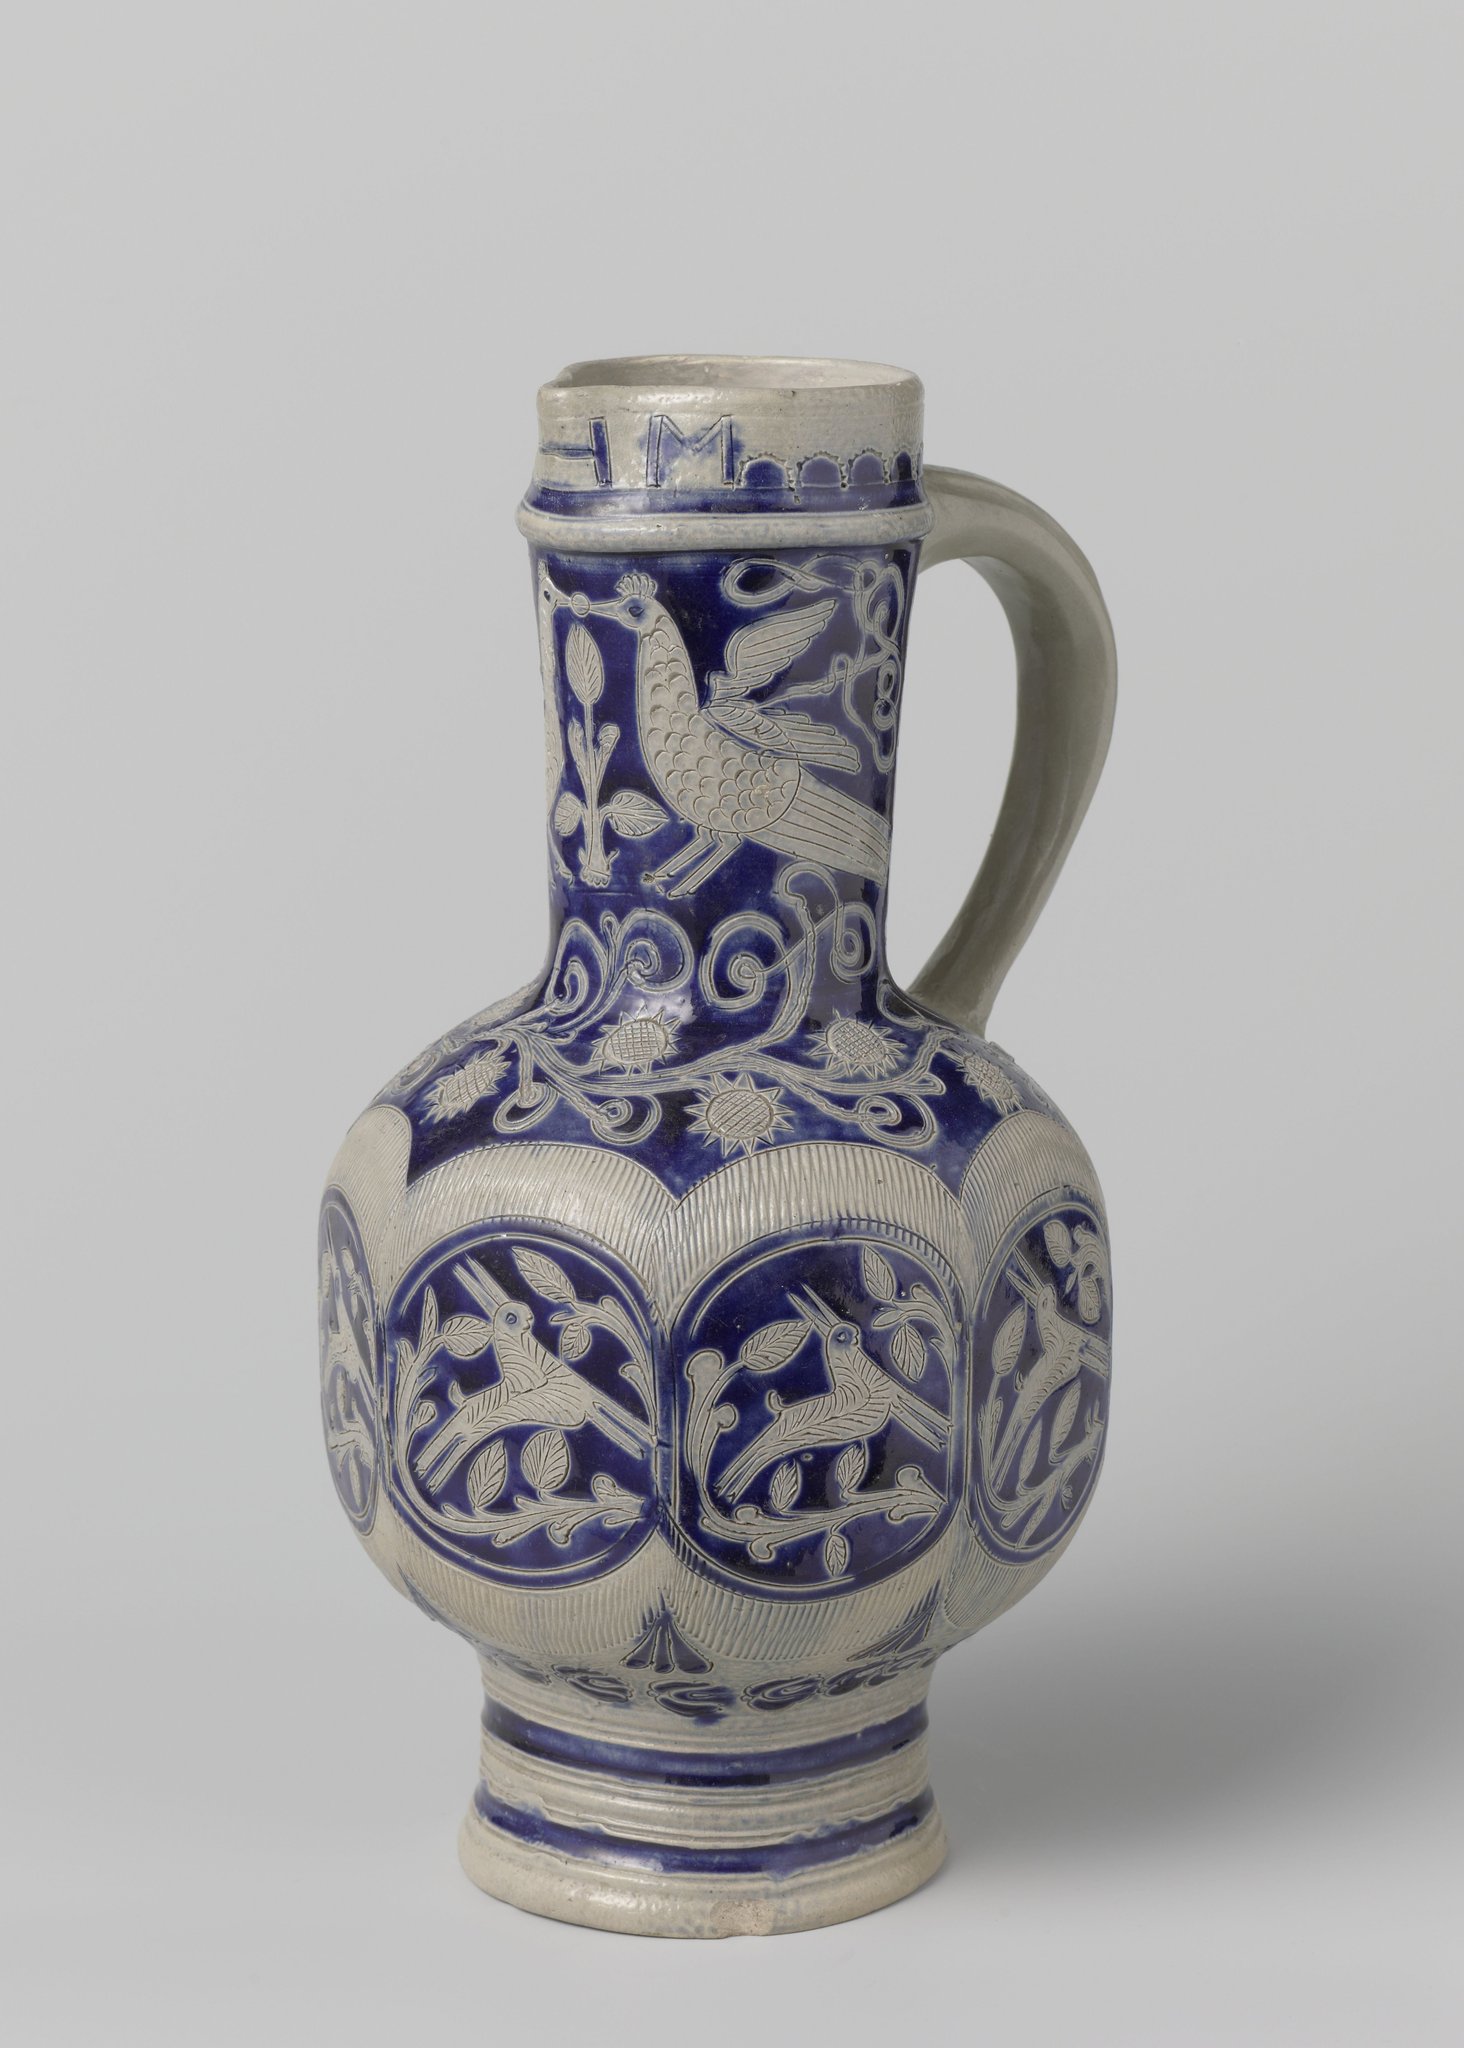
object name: ewer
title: Jug with birds, hare and floral scrolls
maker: Anonymous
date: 1740-1760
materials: cobalt, glaze, stoneware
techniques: printing, firing, forming, turning, vitrification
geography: westerwald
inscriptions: inscription: ‘HM’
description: Kan van steengoed op hoge voet met een bolvormige, achthoekige buik en lange nek met een geknepen tuit. Het C-vormige oor is bevestigd aan de nek en de schouder. Enkele profielen op de nek en voet. Gedeeltelijk bedekt met kobaltblauw. Op de buik acht medaillons omgeven door een ingedrukte zigzaglijn (knibis) en versierd met een haas tussen bladranken. Op de schouder en nek twee vogels tussen bloemranken. Boven de voet een band met gestileerde, gestempelde bloemen. De ingegrifte letters 'HM' op de tuit. Lahntal, Westerwald.